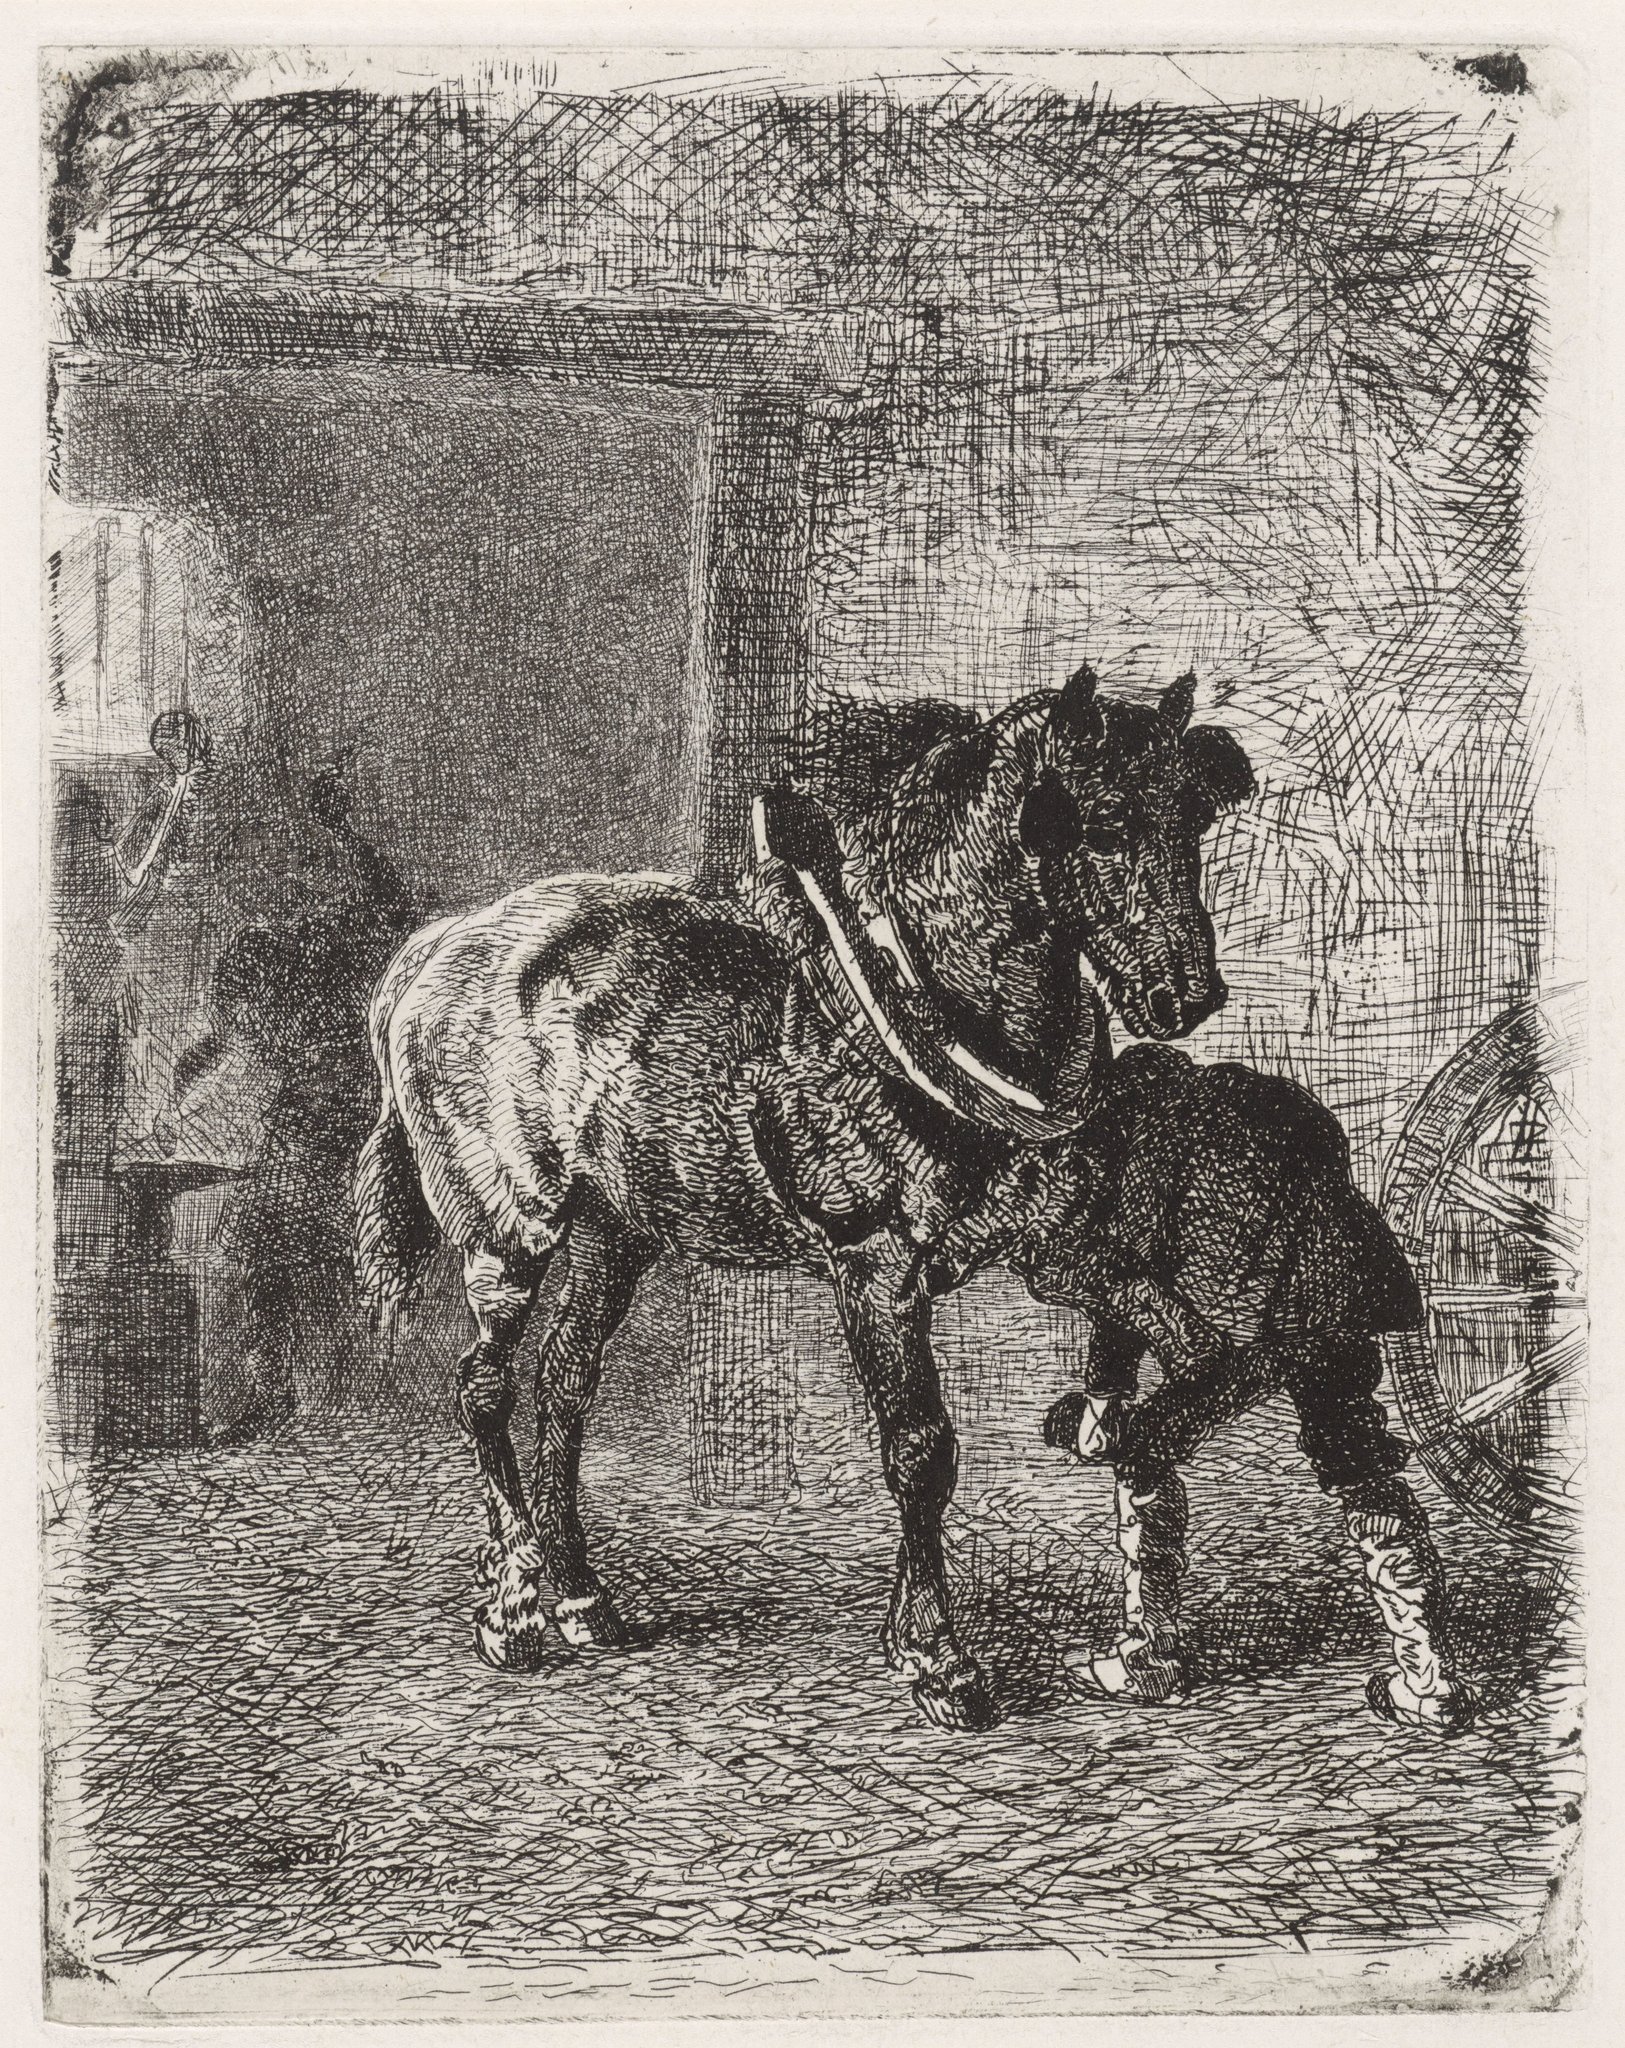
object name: print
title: Paard krijgt hoefijzers in een smederij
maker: cornelis albertus johannes schermer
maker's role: draughtsman, painter, print maker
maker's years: 1824-1915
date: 1839-1915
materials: paper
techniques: etching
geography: the hague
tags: farrier, shoeing-smith, horse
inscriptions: collector's mark: Lugt 2228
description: Vooraan beslaat een man de hoef van een paard. Achter hem is een smid in een smederij aan het werk bij een aambeeld.